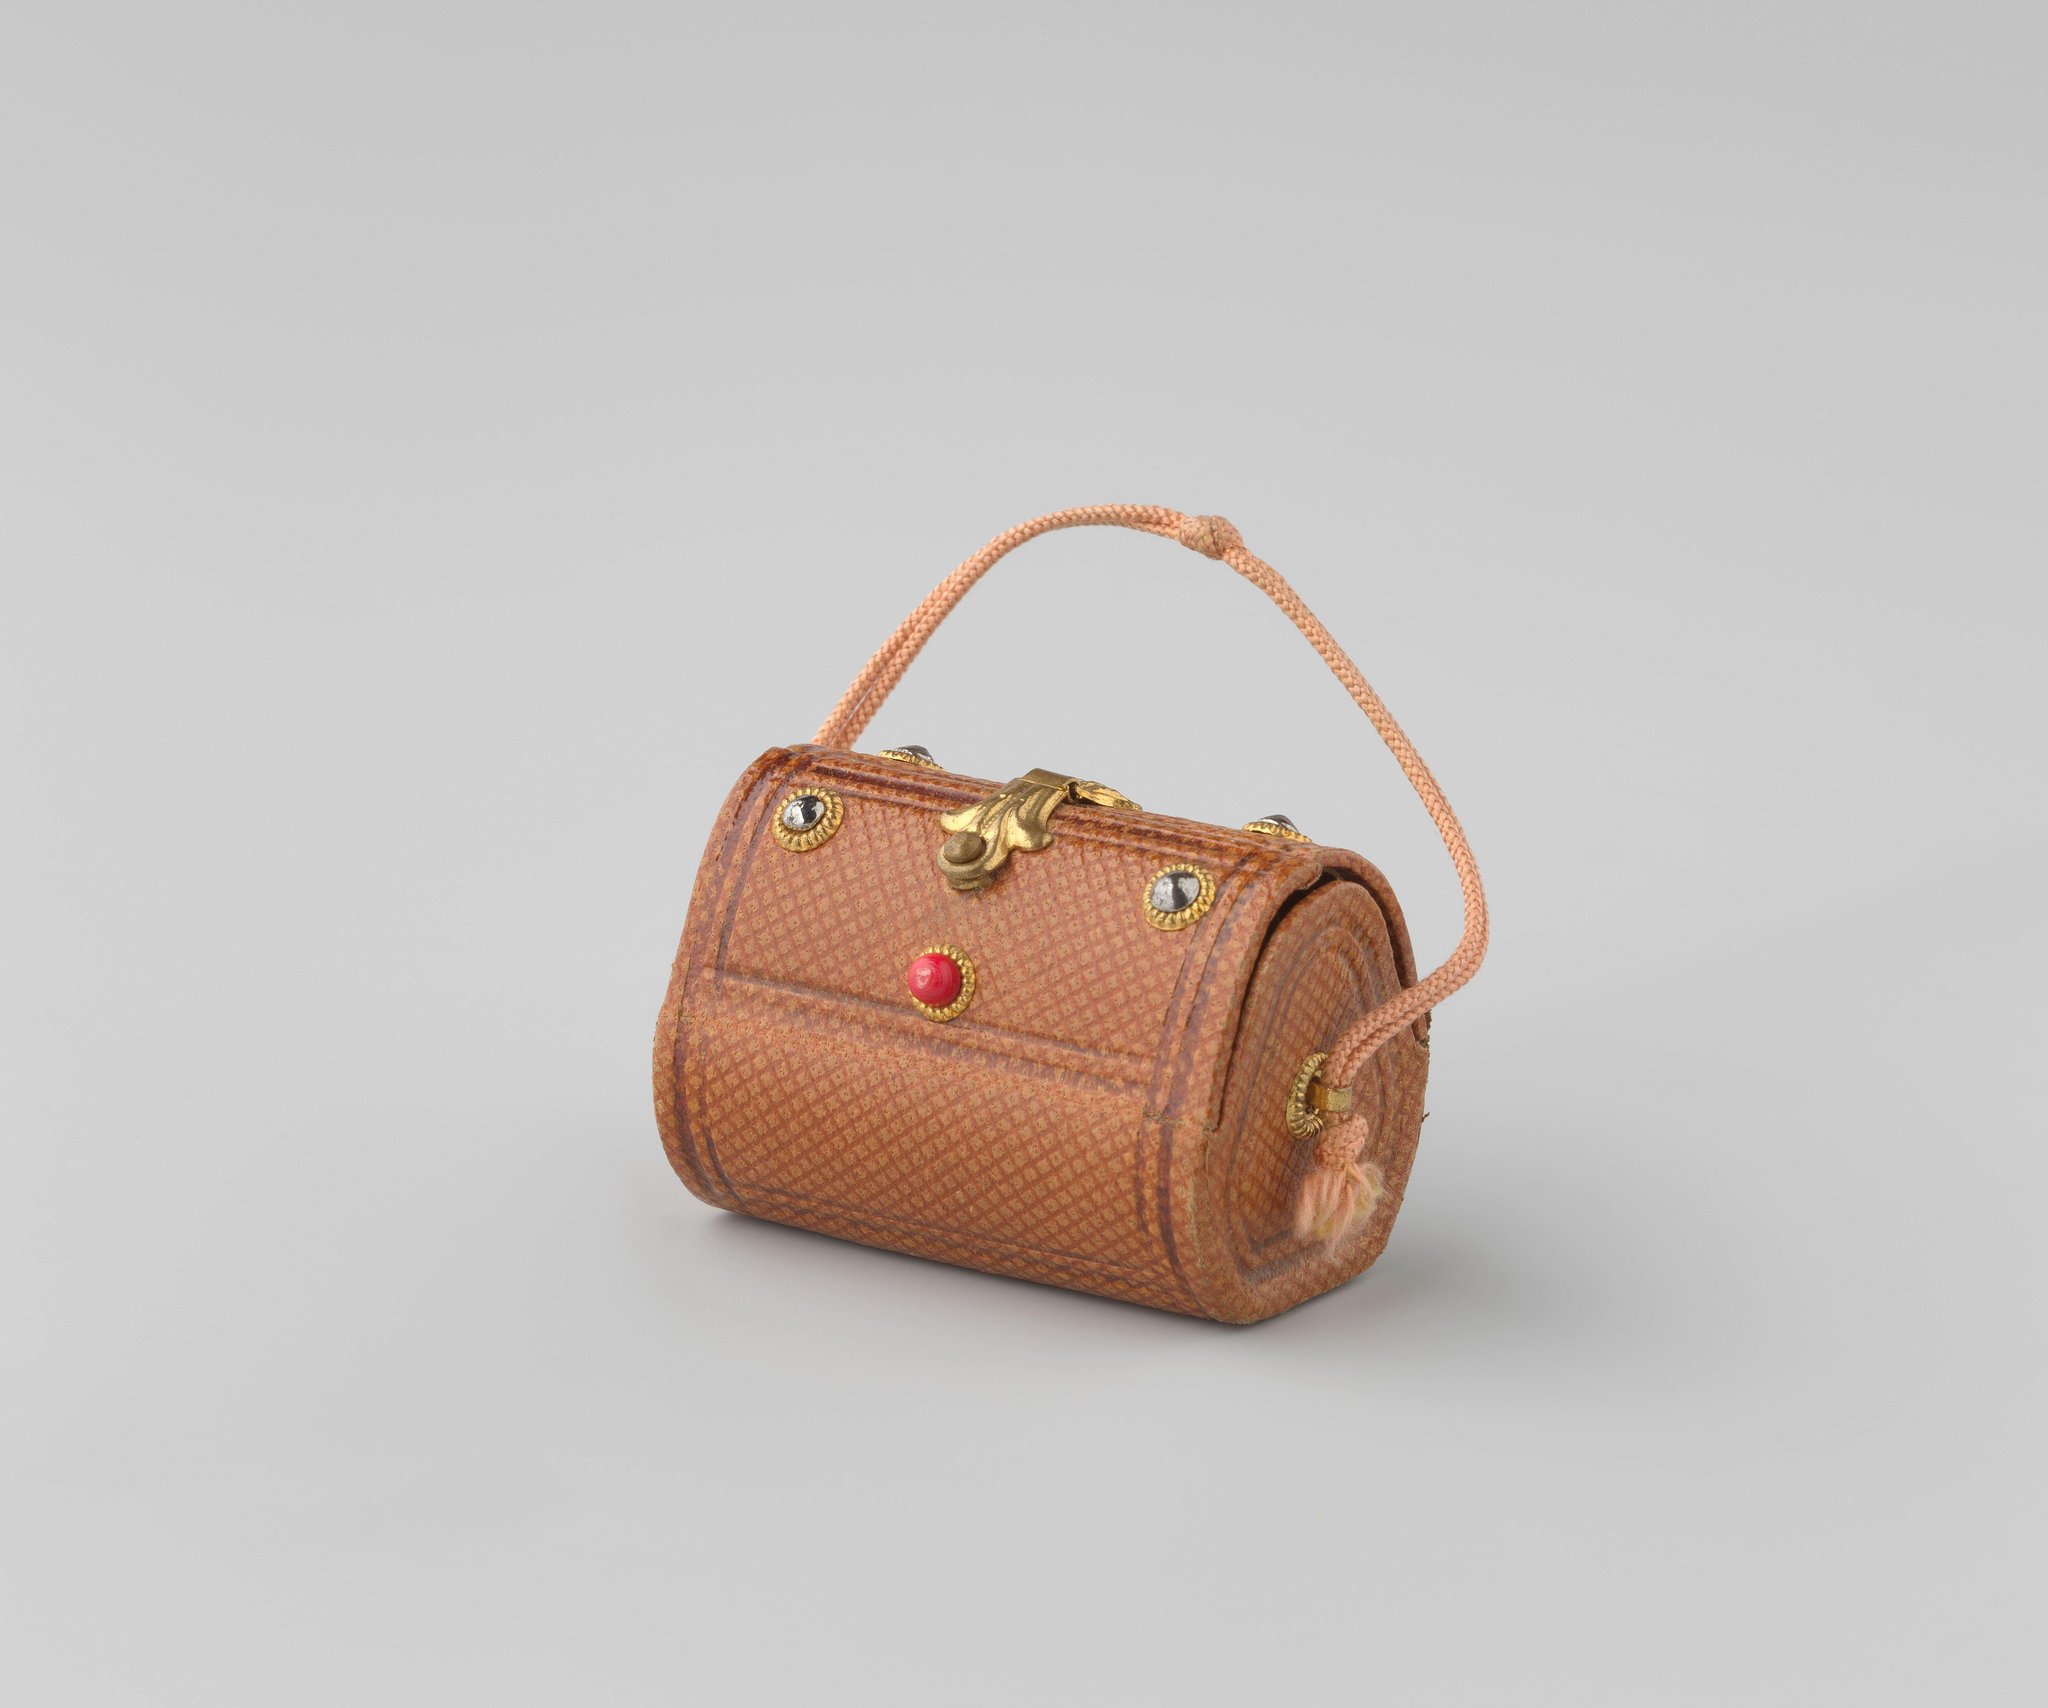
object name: clothing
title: Tas, bol model, bezet met namaak stenen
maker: Anonymous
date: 1880-1890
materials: leather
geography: netherlands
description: Tas, bol model, bezet met namaak stenen.